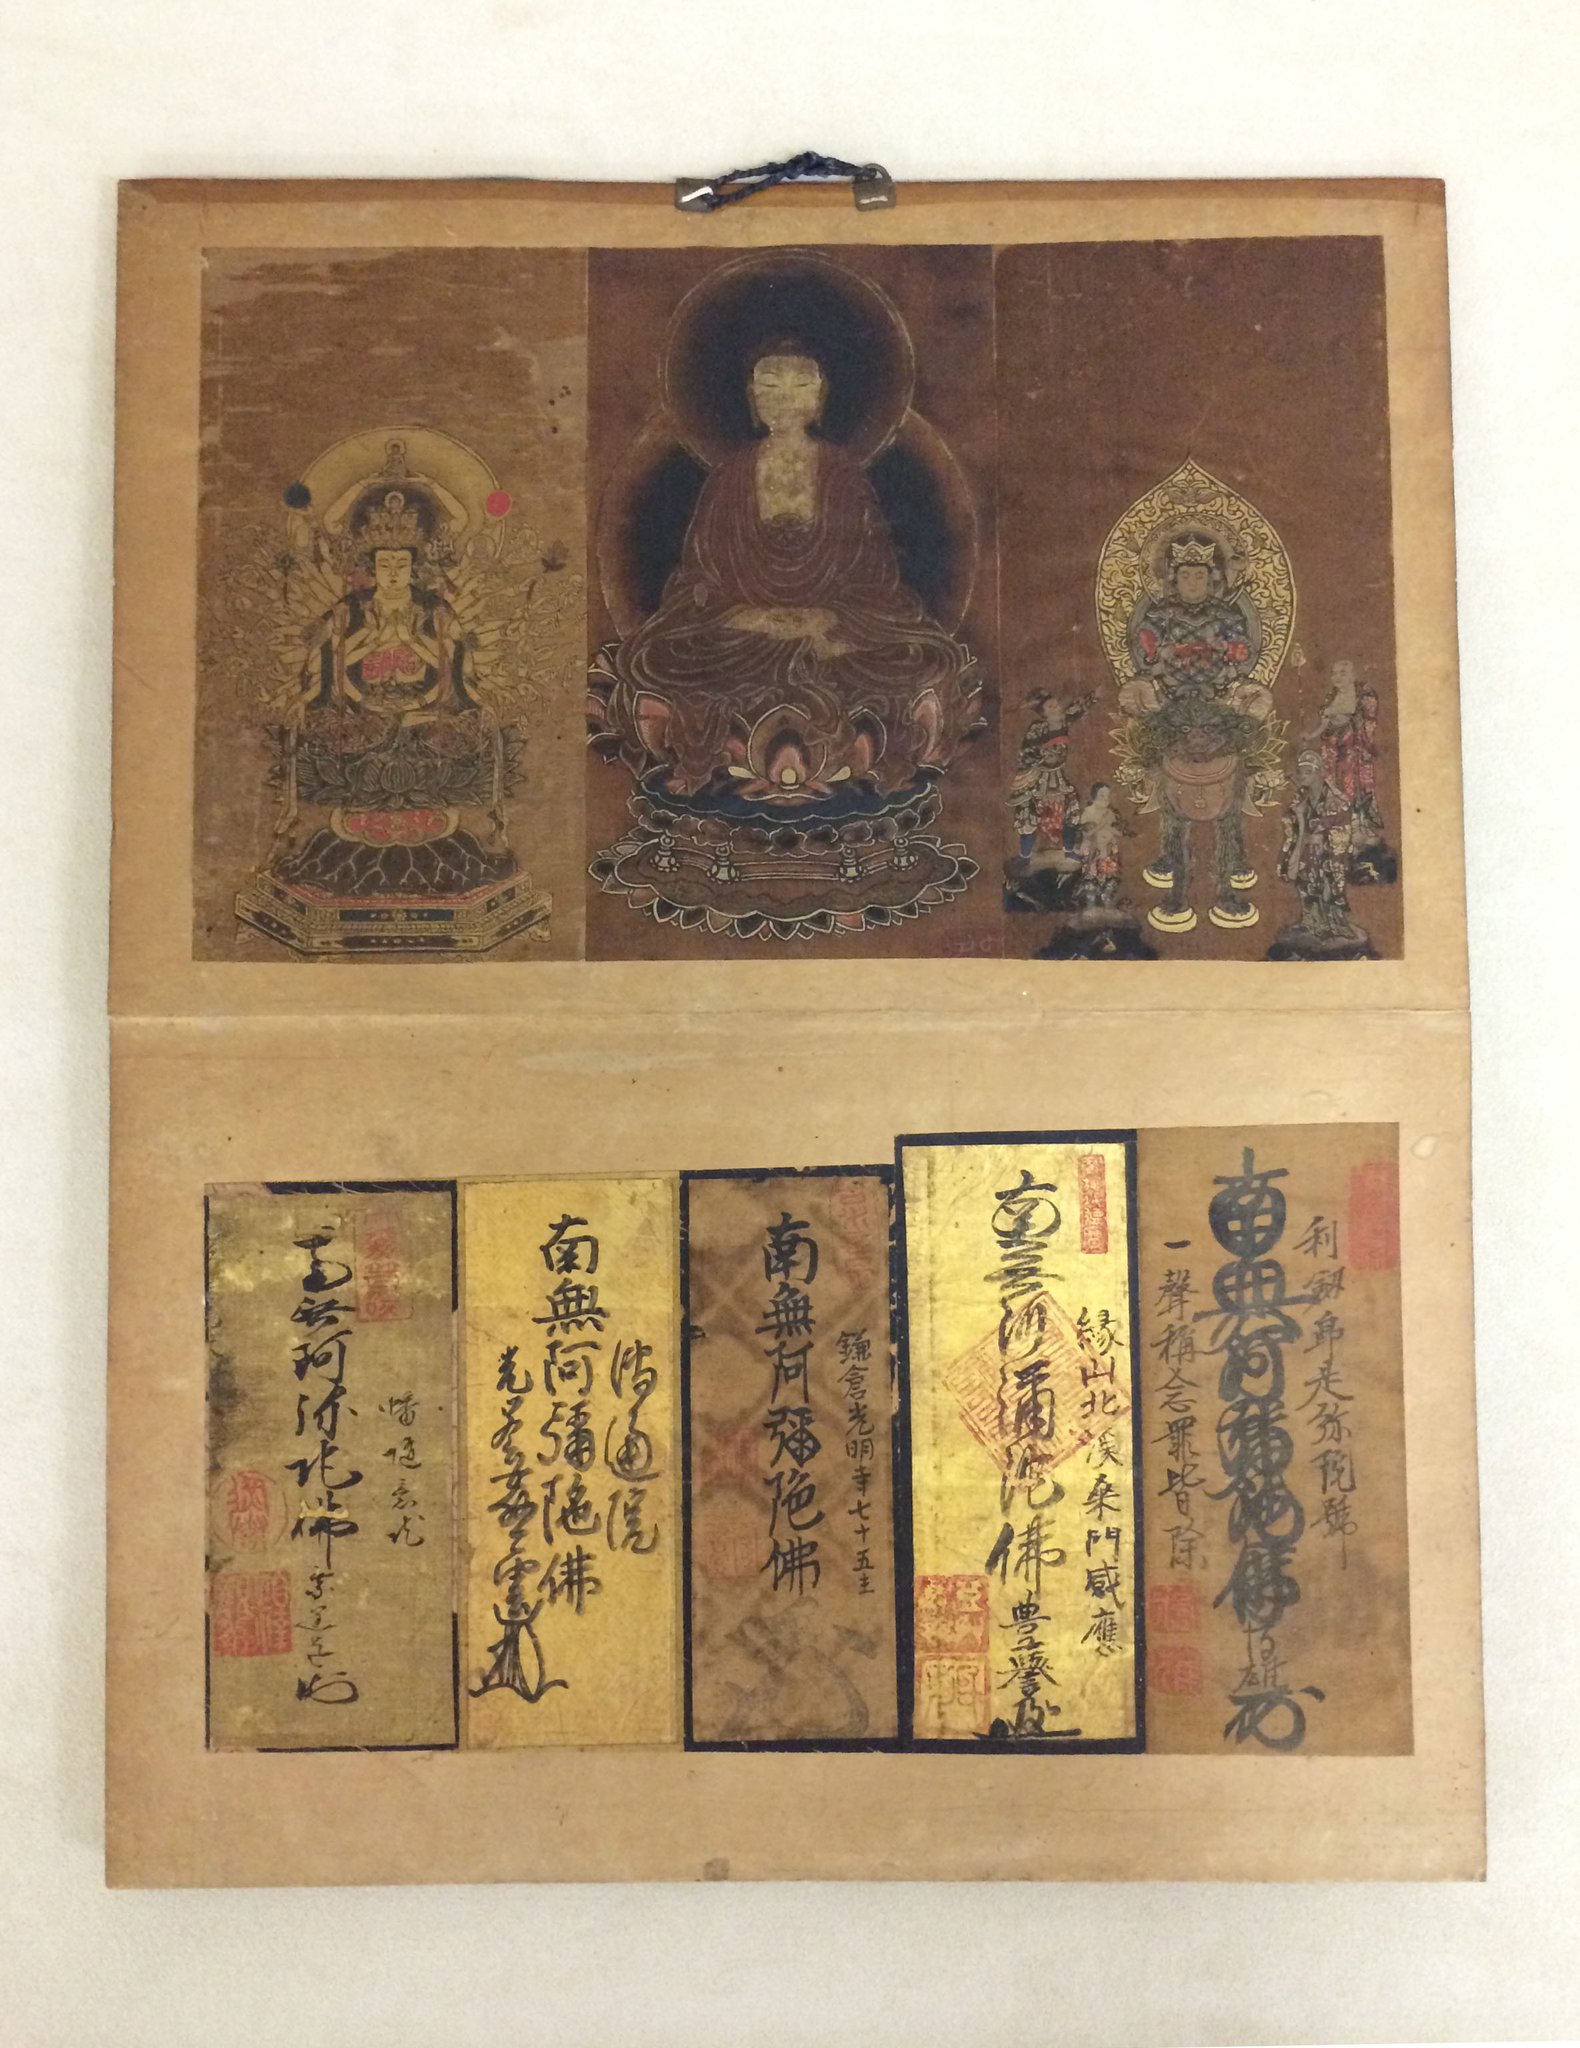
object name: book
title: Pilgrim's Visiting Album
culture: japanese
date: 1701-1800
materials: gilt, gold, ink, metal thread, paper, silk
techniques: calligraphy, embroidery, painting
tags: buddhism